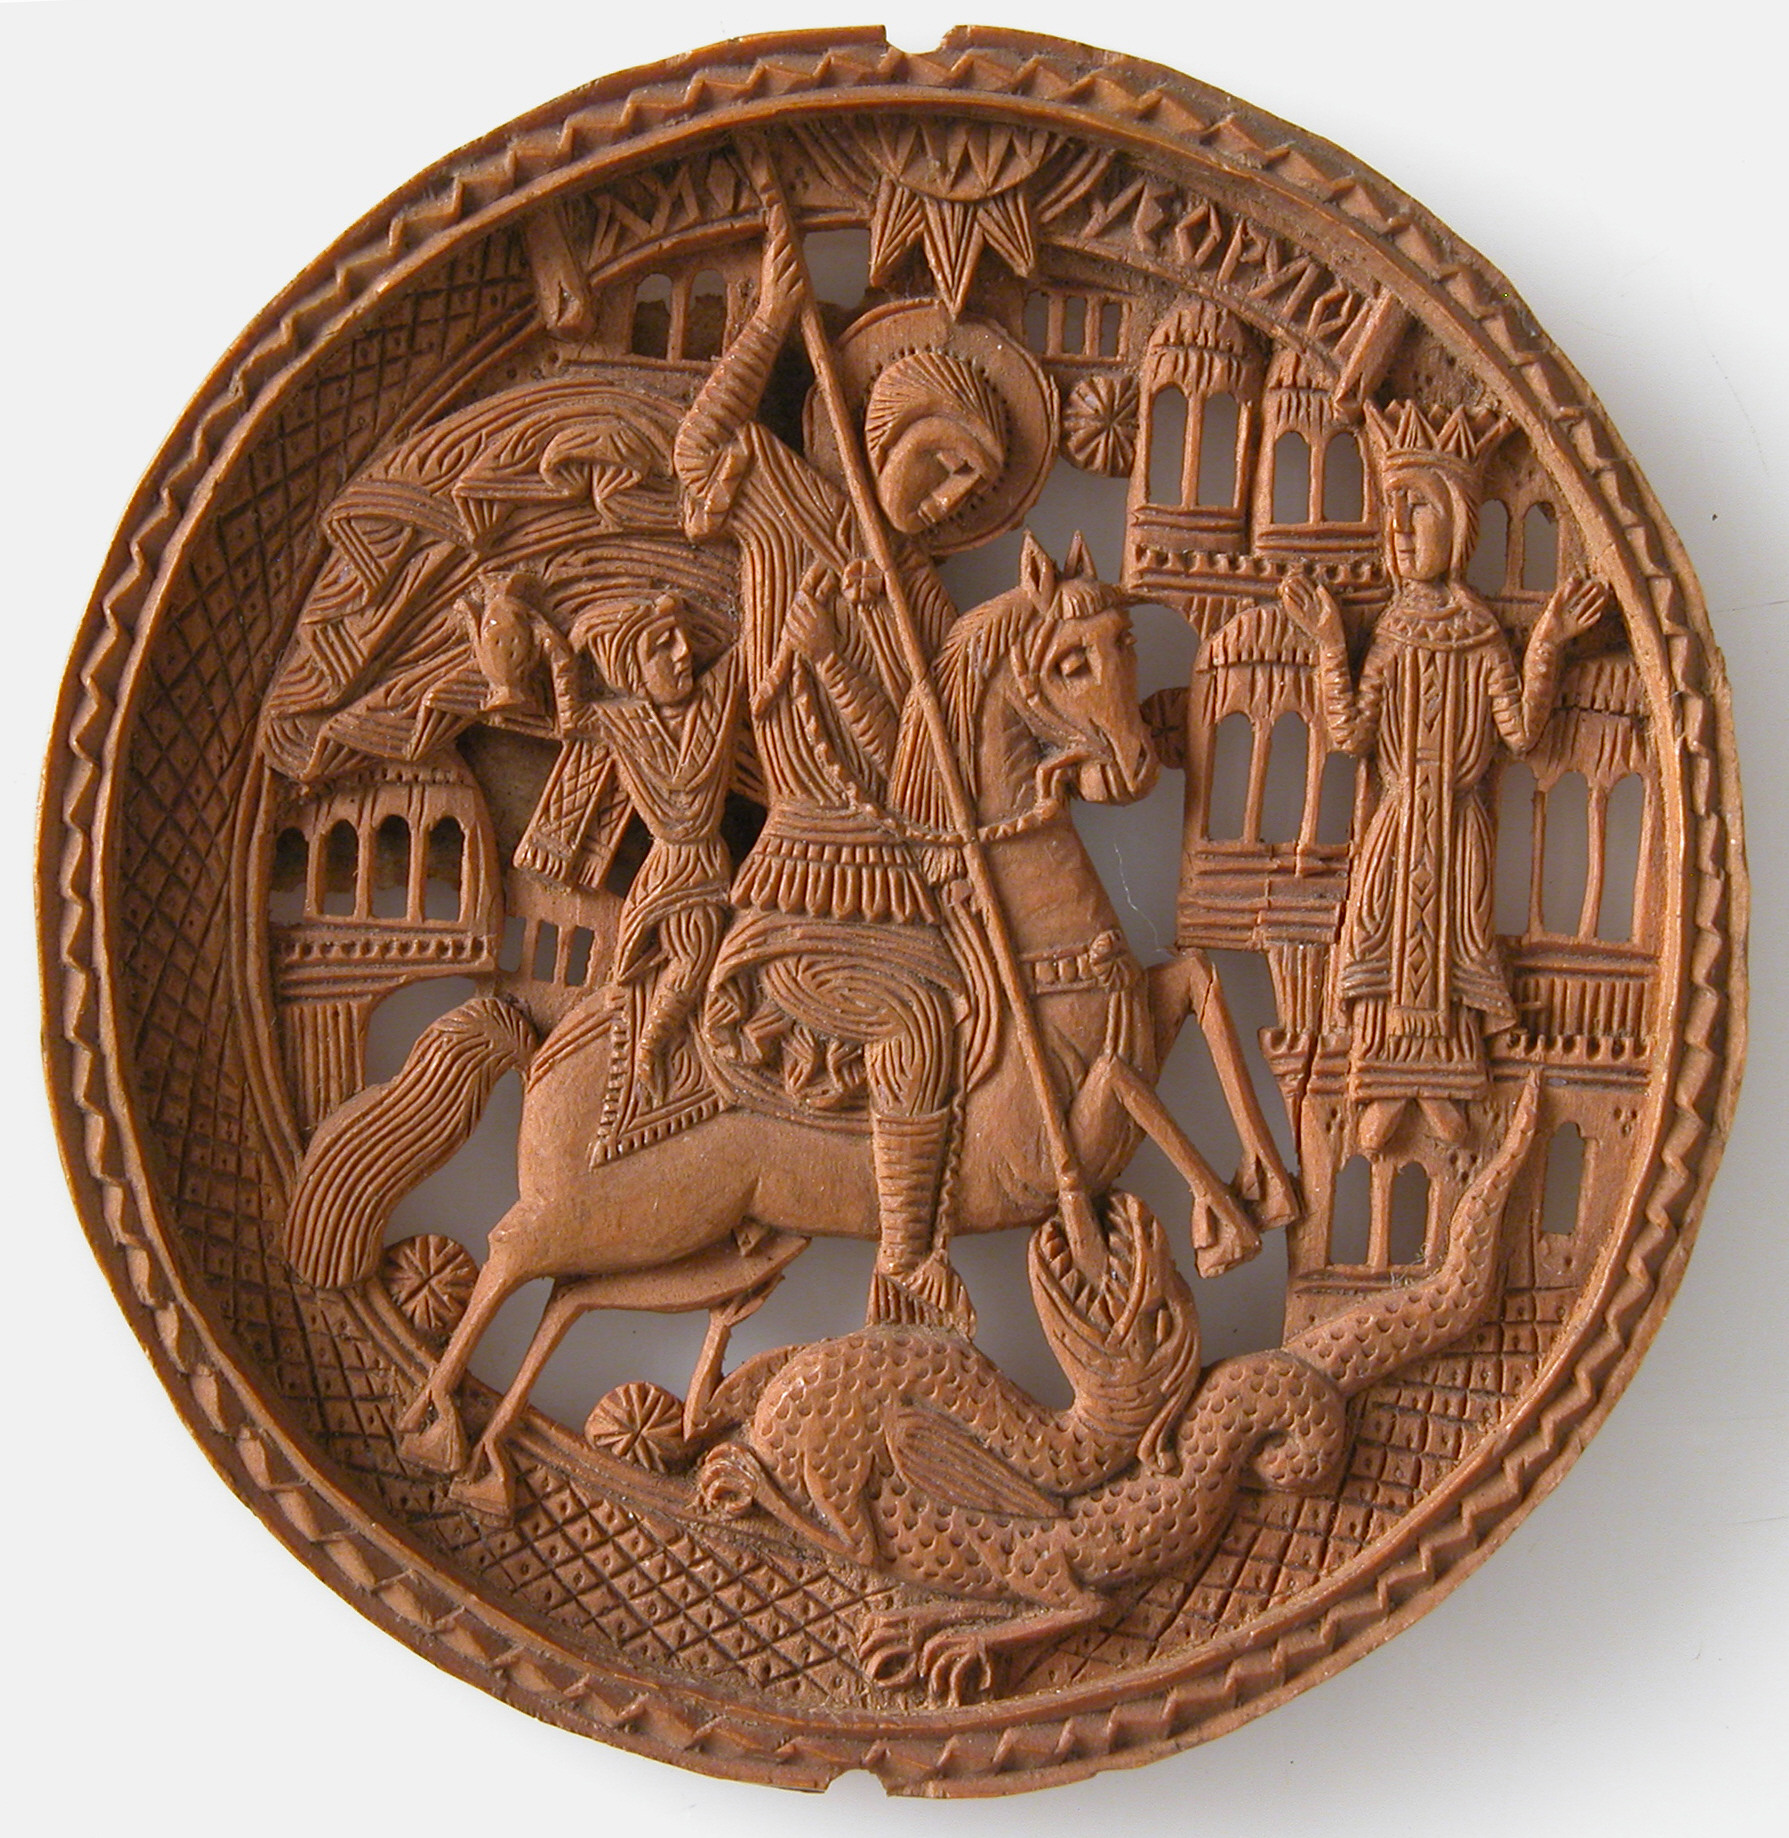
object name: medallion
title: Medallion, St. George Slaying The Dragon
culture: slavic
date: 1601-1700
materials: wood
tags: dragons,horses,saint george